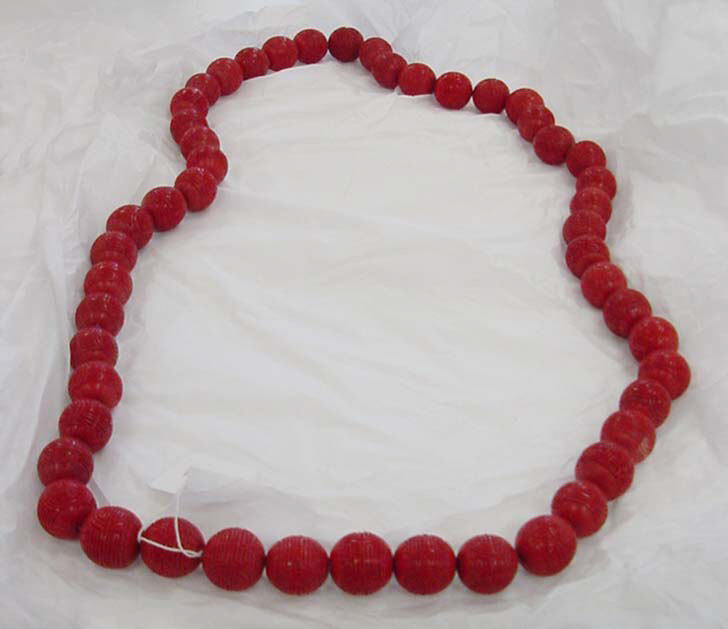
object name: necklace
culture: chinese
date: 1801-1900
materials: cotton, wood